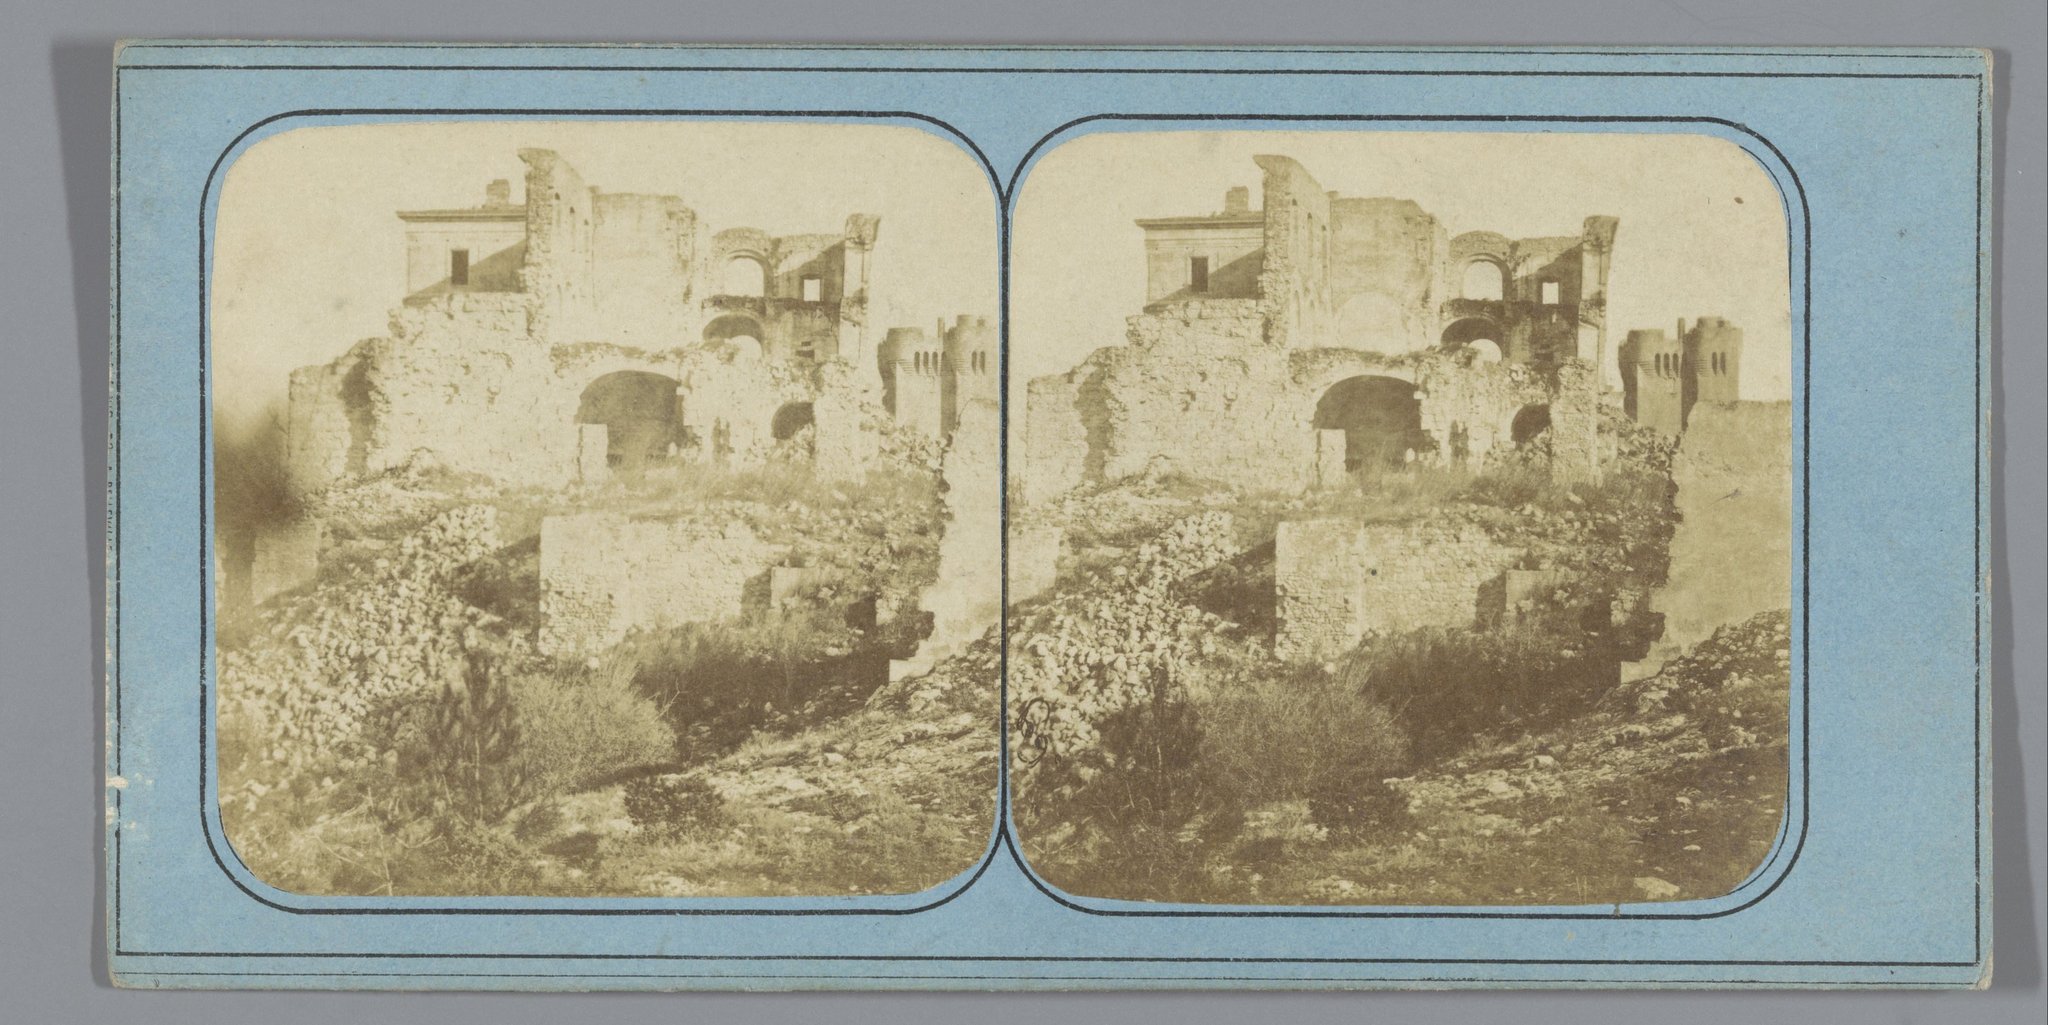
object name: stereograph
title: Ruïne van een kasteel of fort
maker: Anonymous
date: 1866-1870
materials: cardboard, paper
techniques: albumen print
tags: ruin of a dwelling, house, castle, etc.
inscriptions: number: ‘No.34’